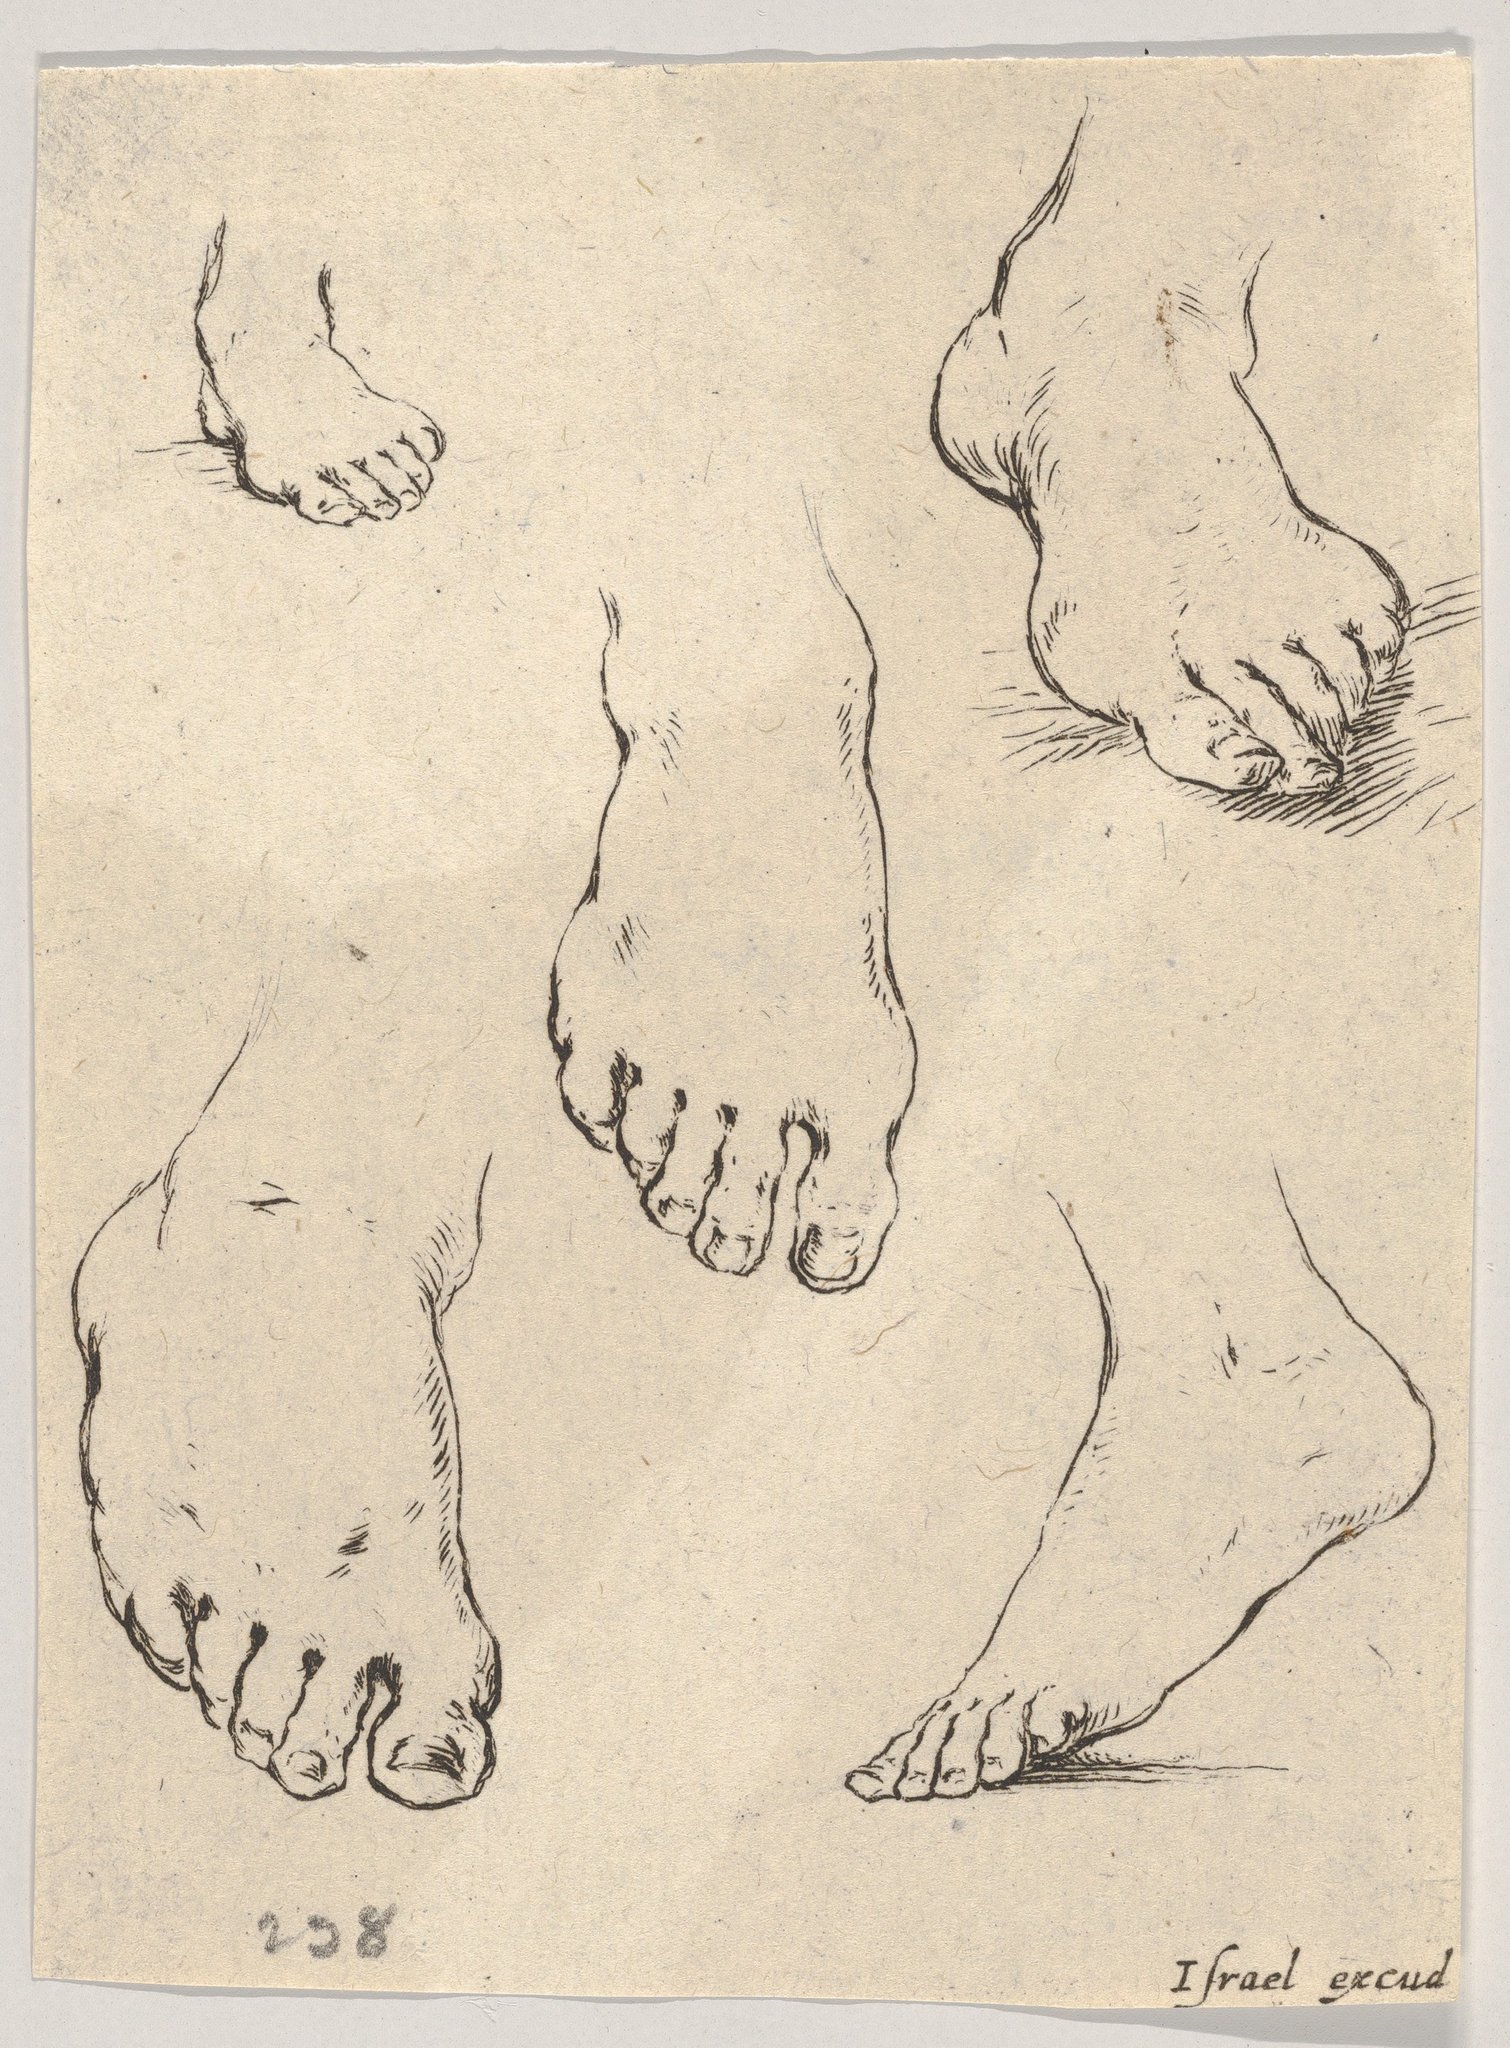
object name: print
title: Plate 7: Five feet, from "The Book for Learning to Draw" (Livre pour apprendre à dessiner)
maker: stefano della bella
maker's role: artist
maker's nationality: italian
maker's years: 1610-1664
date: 1649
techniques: etching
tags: feet